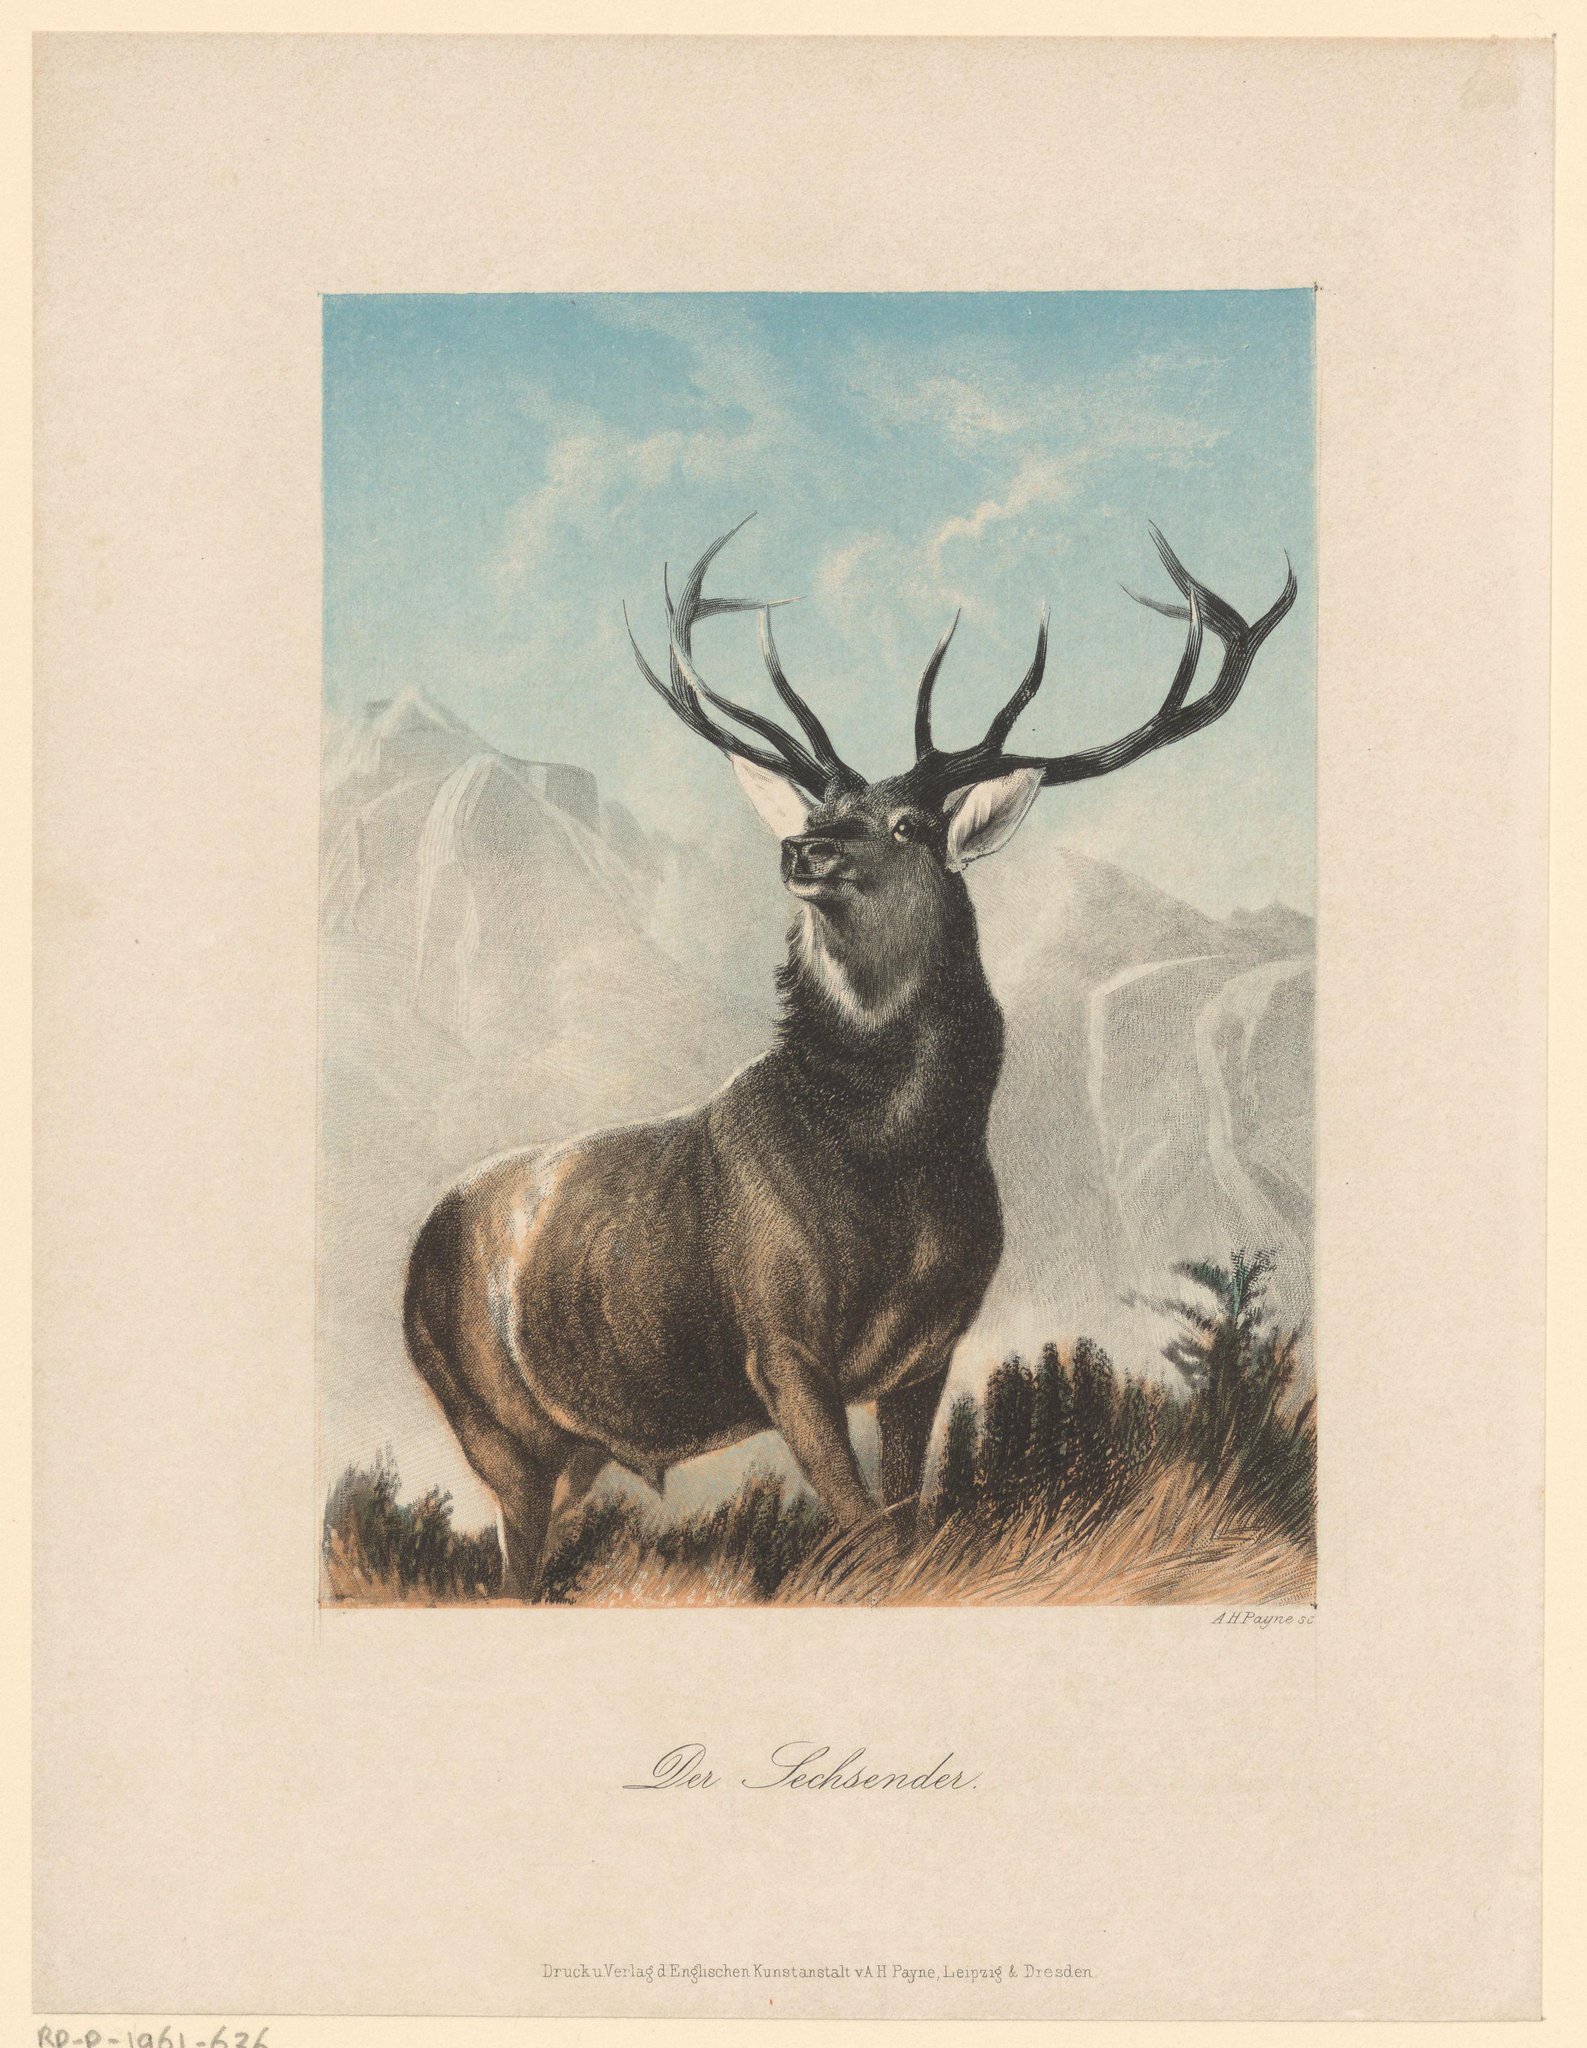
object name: print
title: Hert in de bergen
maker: albert henry payne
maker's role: print maker, publisher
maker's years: 1812-1902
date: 1845-1902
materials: paper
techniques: etching, hand coloring, iris print, roulette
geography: leipzig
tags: hoofed animals: deer, mountains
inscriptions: collector's mark: Lugt 2228